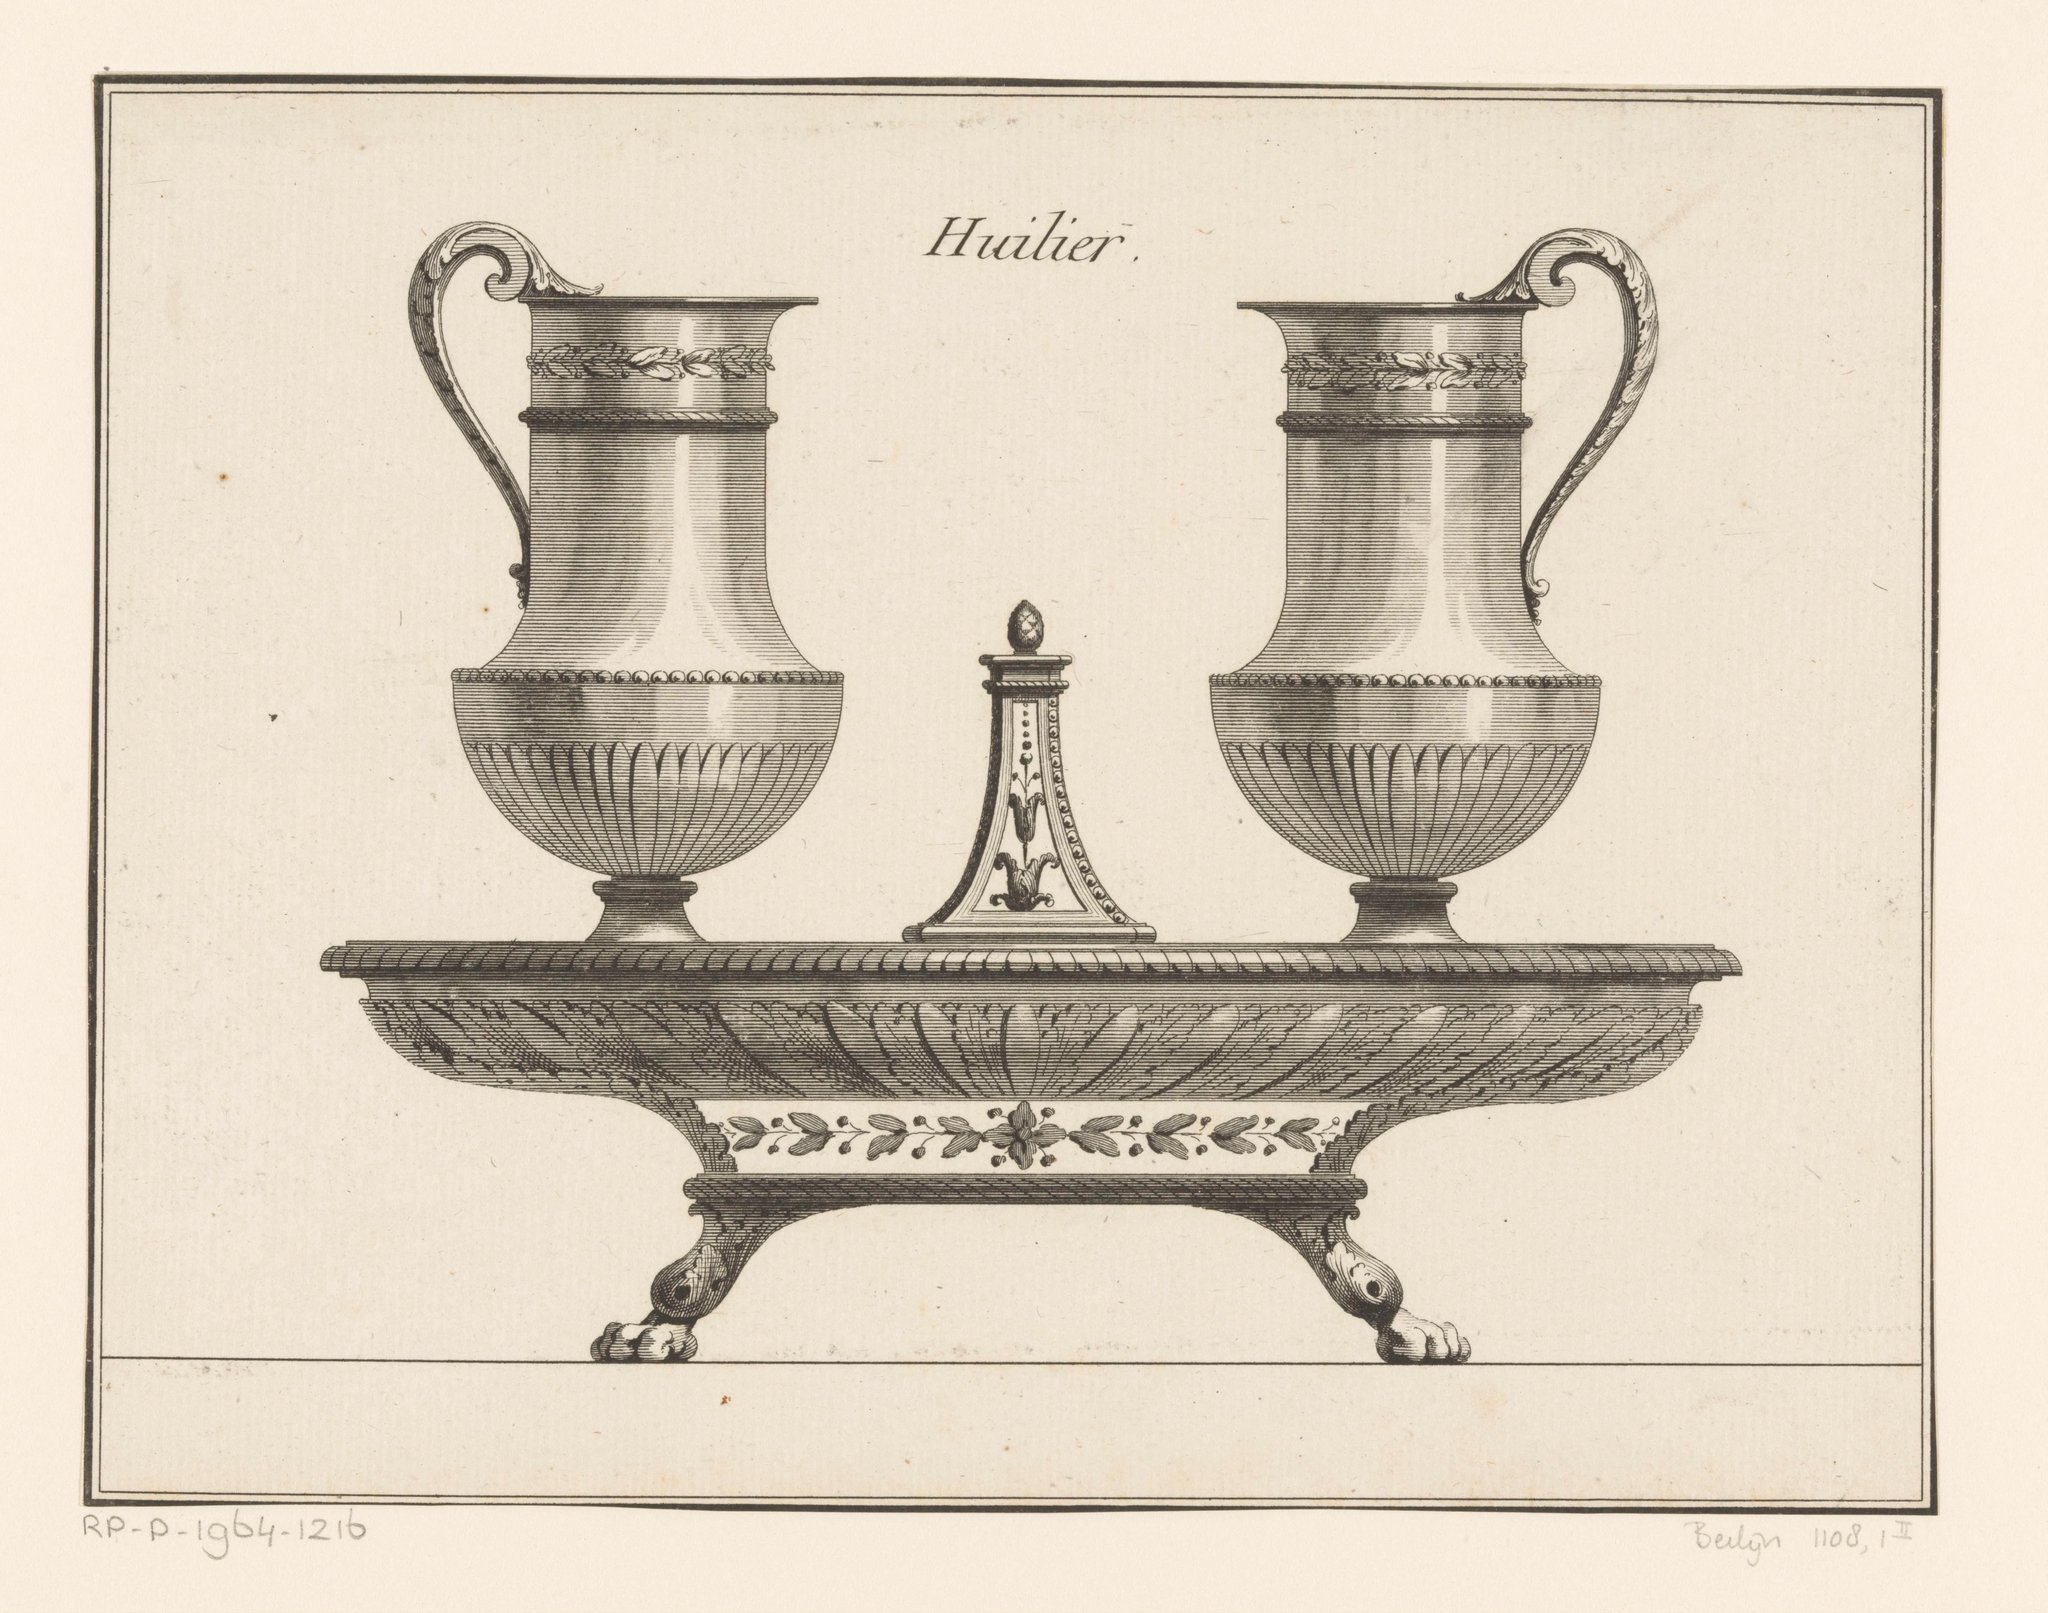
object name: print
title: Oliestel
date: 1789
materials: paper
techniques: engraving, etching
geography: paris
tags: serving-dish, platter, oils and vegetable fats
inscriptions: collector's mark: Lugt 2228, collector's mark: Lugt 2760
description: Een oliestel op een geornamenteerd blad op leeuwenpoten.